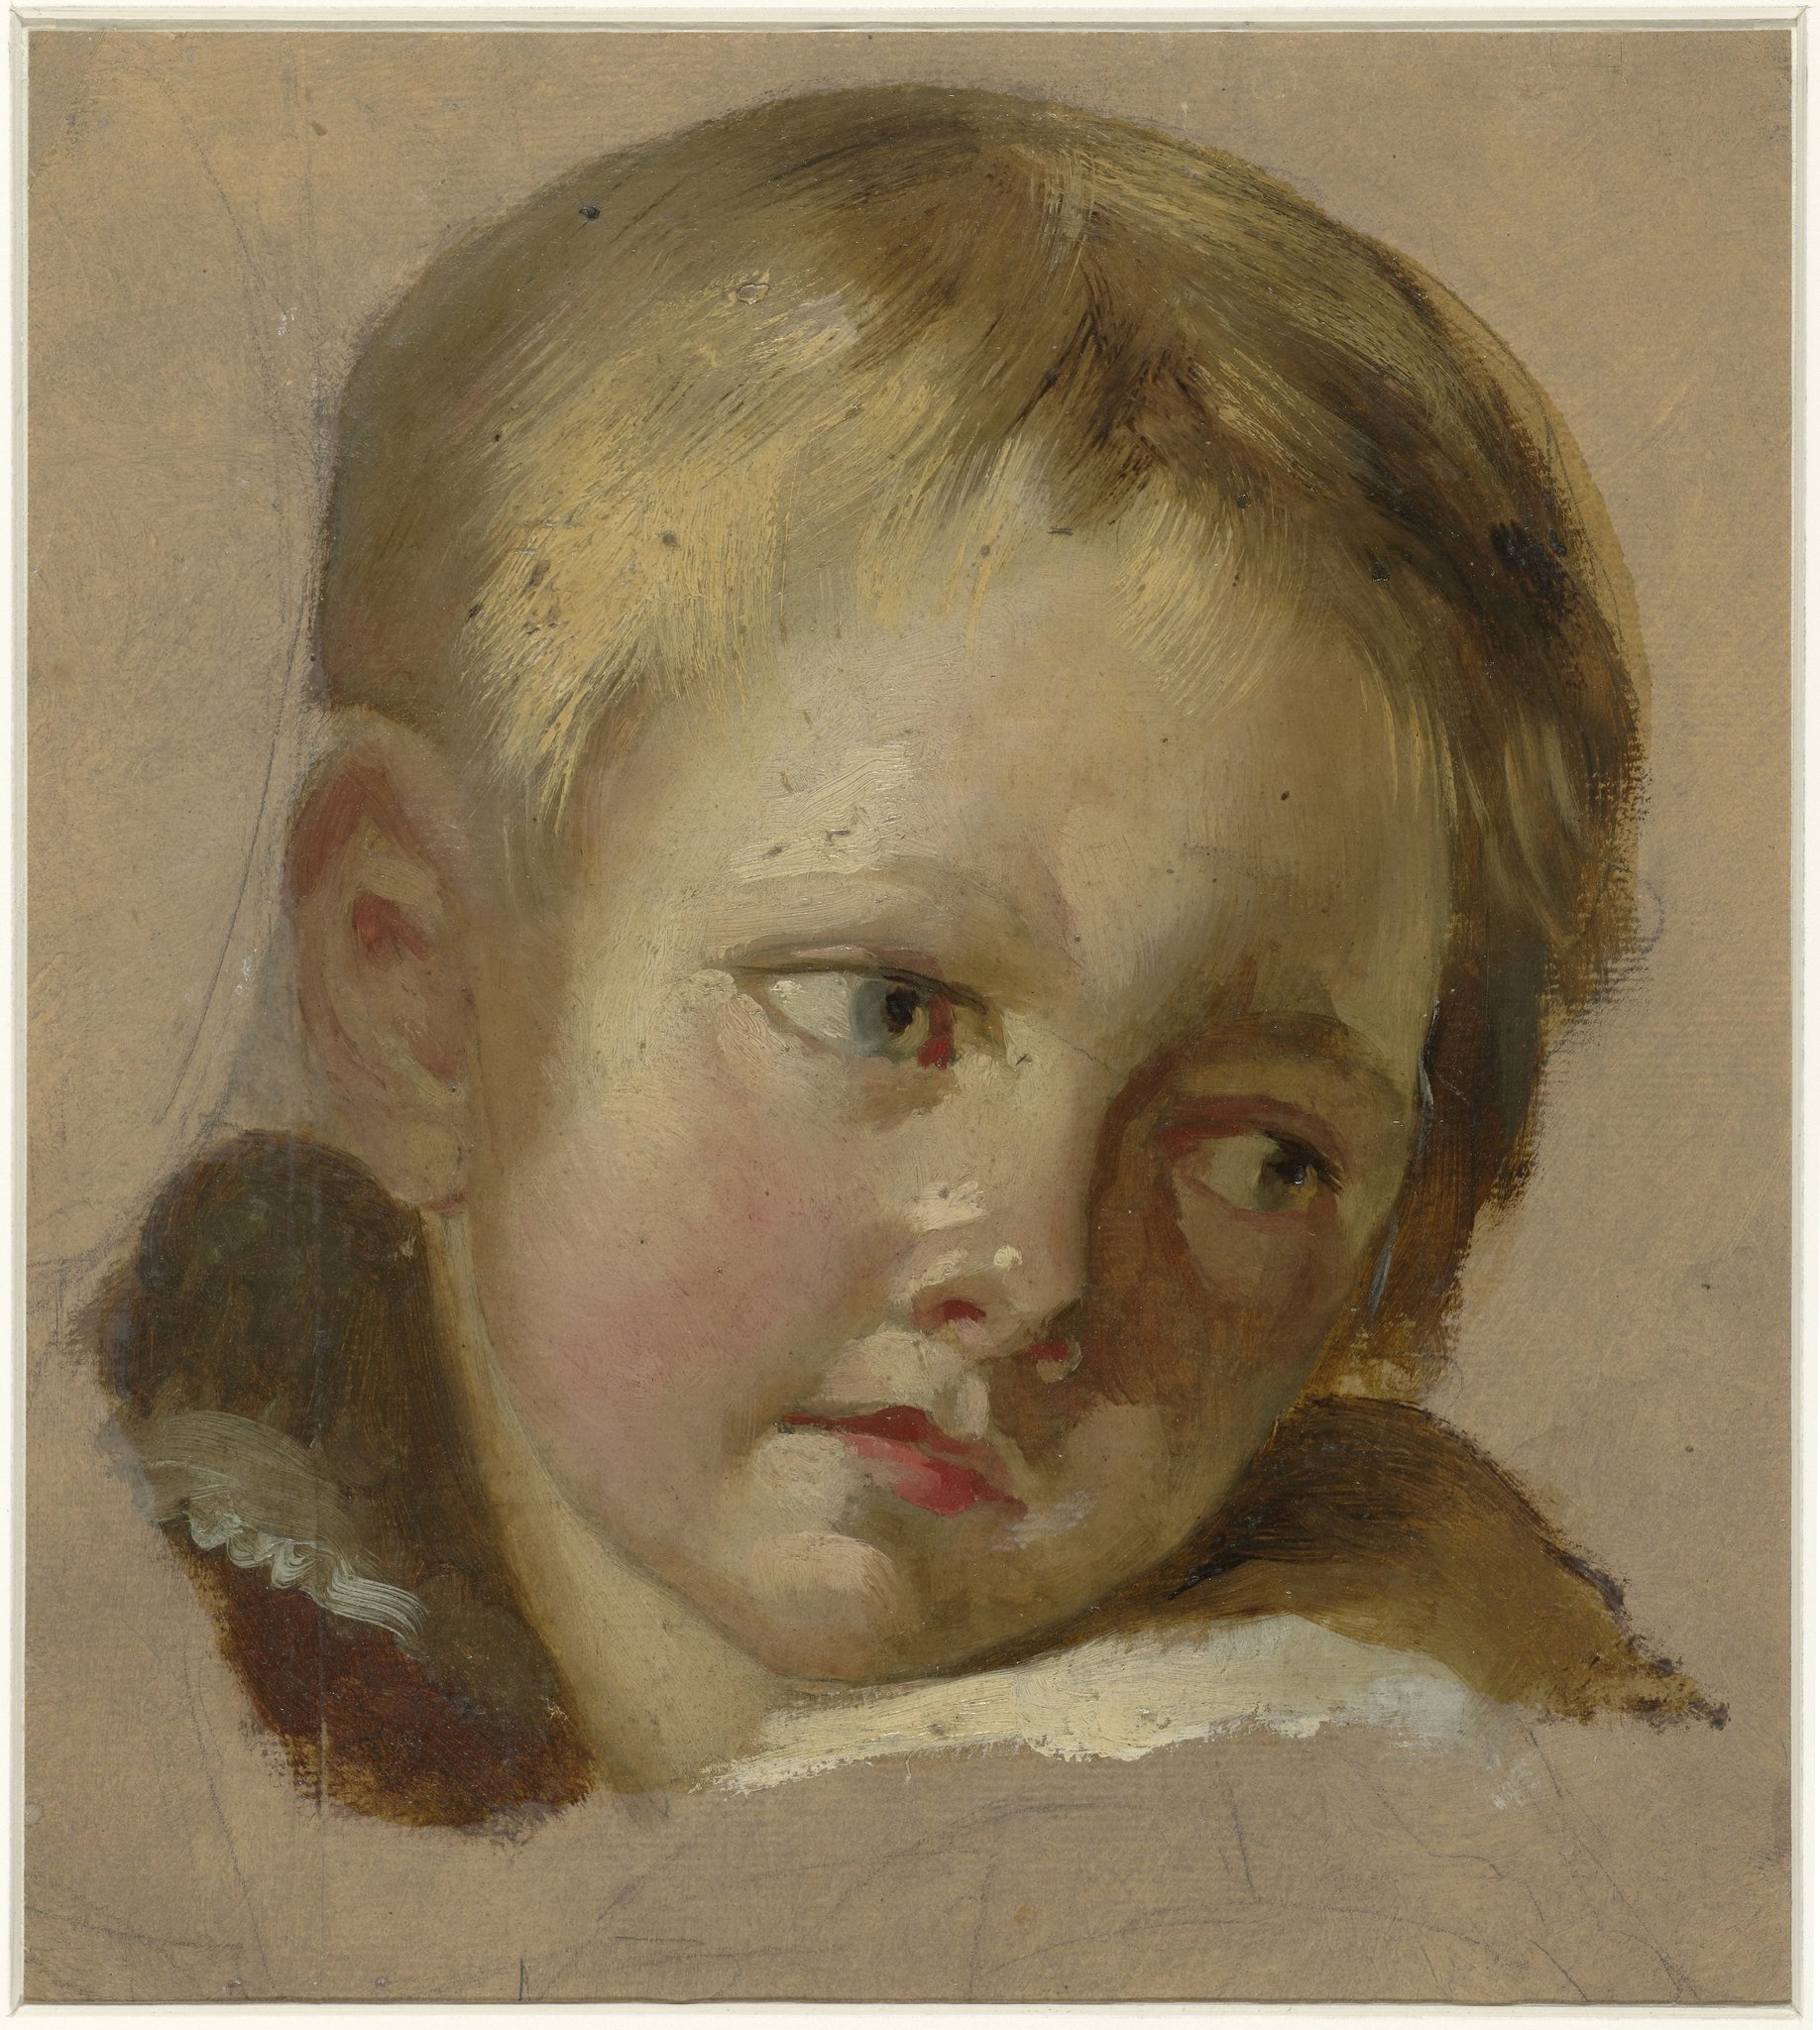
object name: drawing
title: Schets van een kinderkopje met lichtblond haar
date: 1771-1845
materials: chalk, oil, pencil, paper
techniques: brush, varnishing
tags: boy (child between toddler and youth)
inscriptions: collector's mark, verso, on the passepartout: Lugt 2228